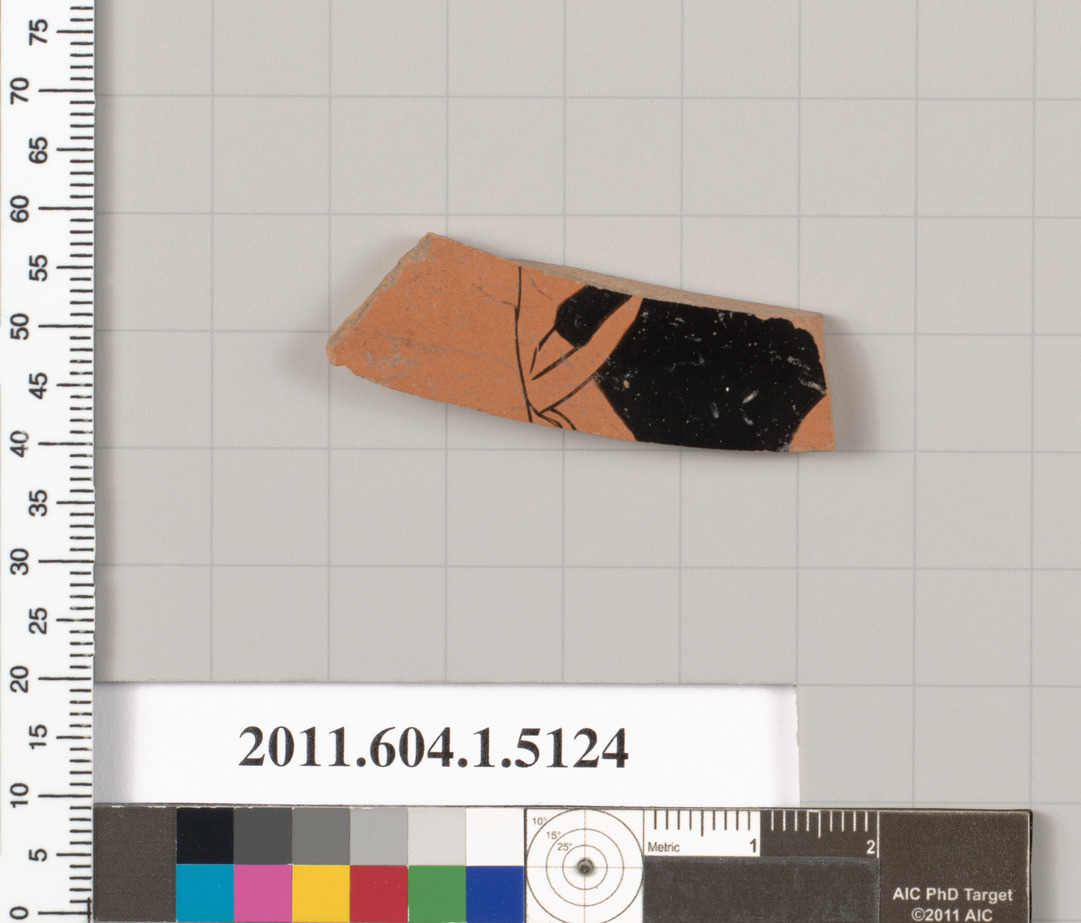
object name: kylix fragment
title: Terracotta fragment of a kylix (drinking cup)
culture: greek, attic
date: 490-480 BCE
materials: terracotta